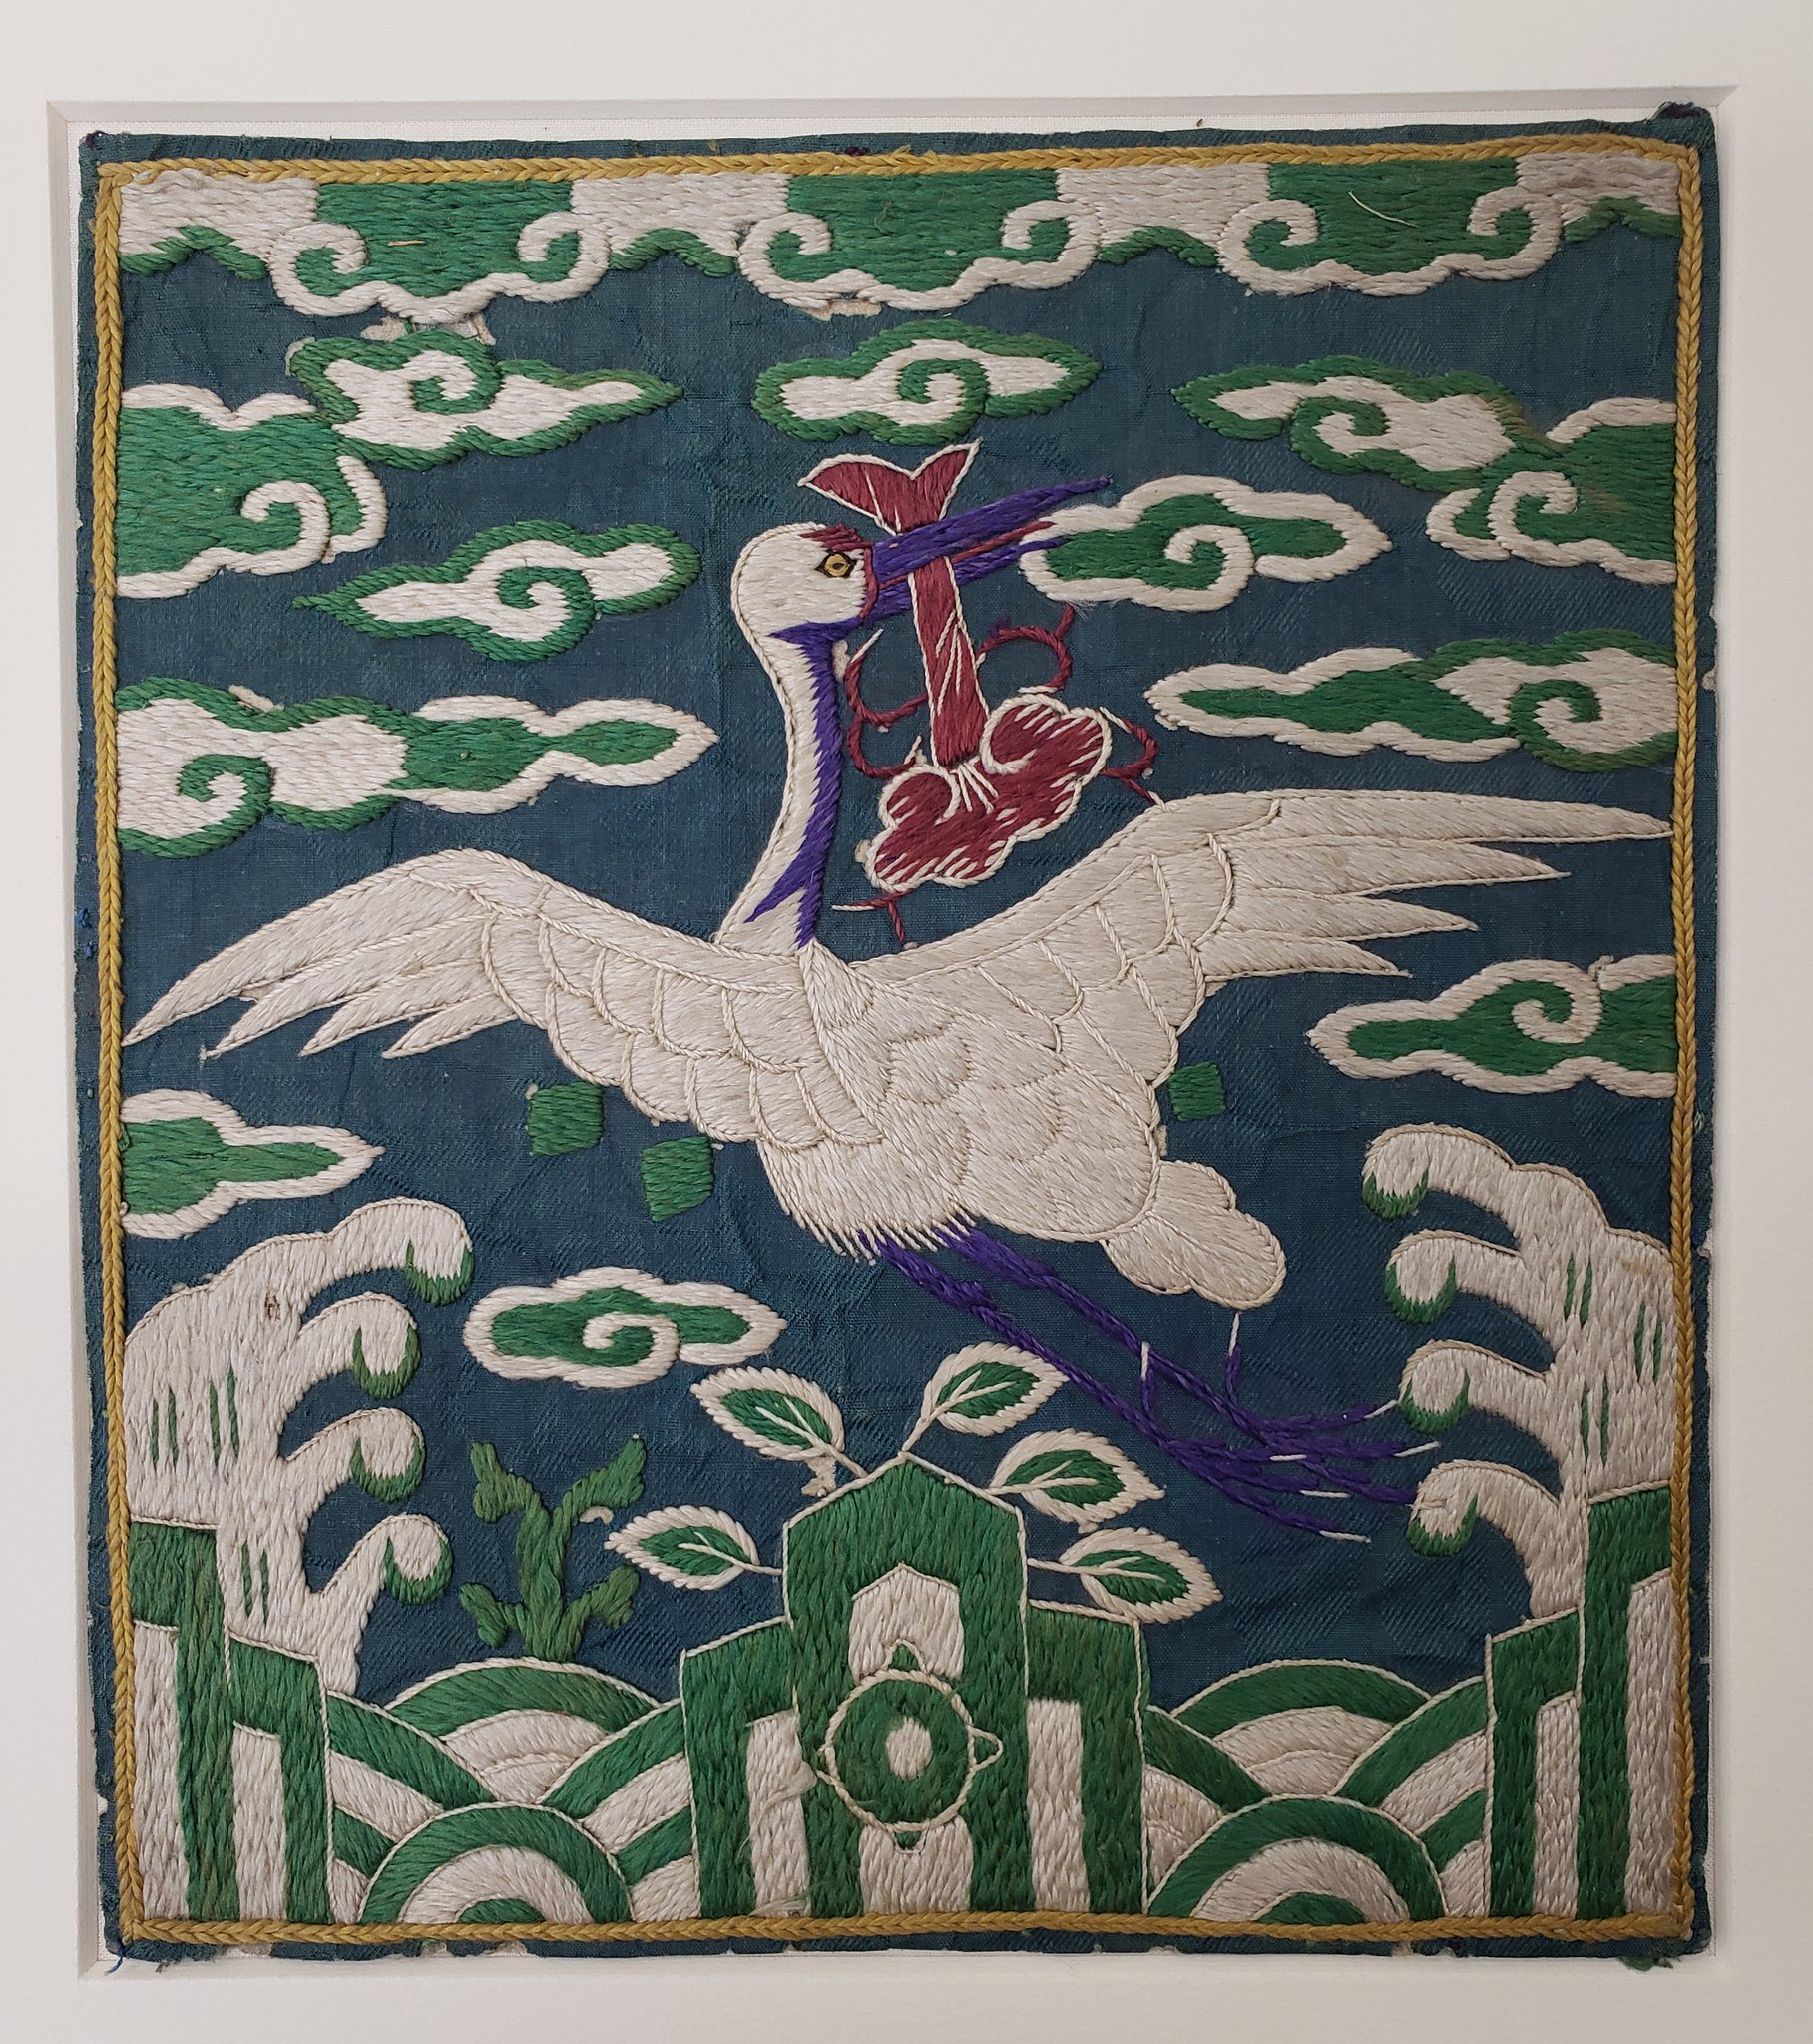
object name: rank badge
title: Rank Badge with White Crane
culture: korean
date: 1867-1900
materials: silk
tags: cranes